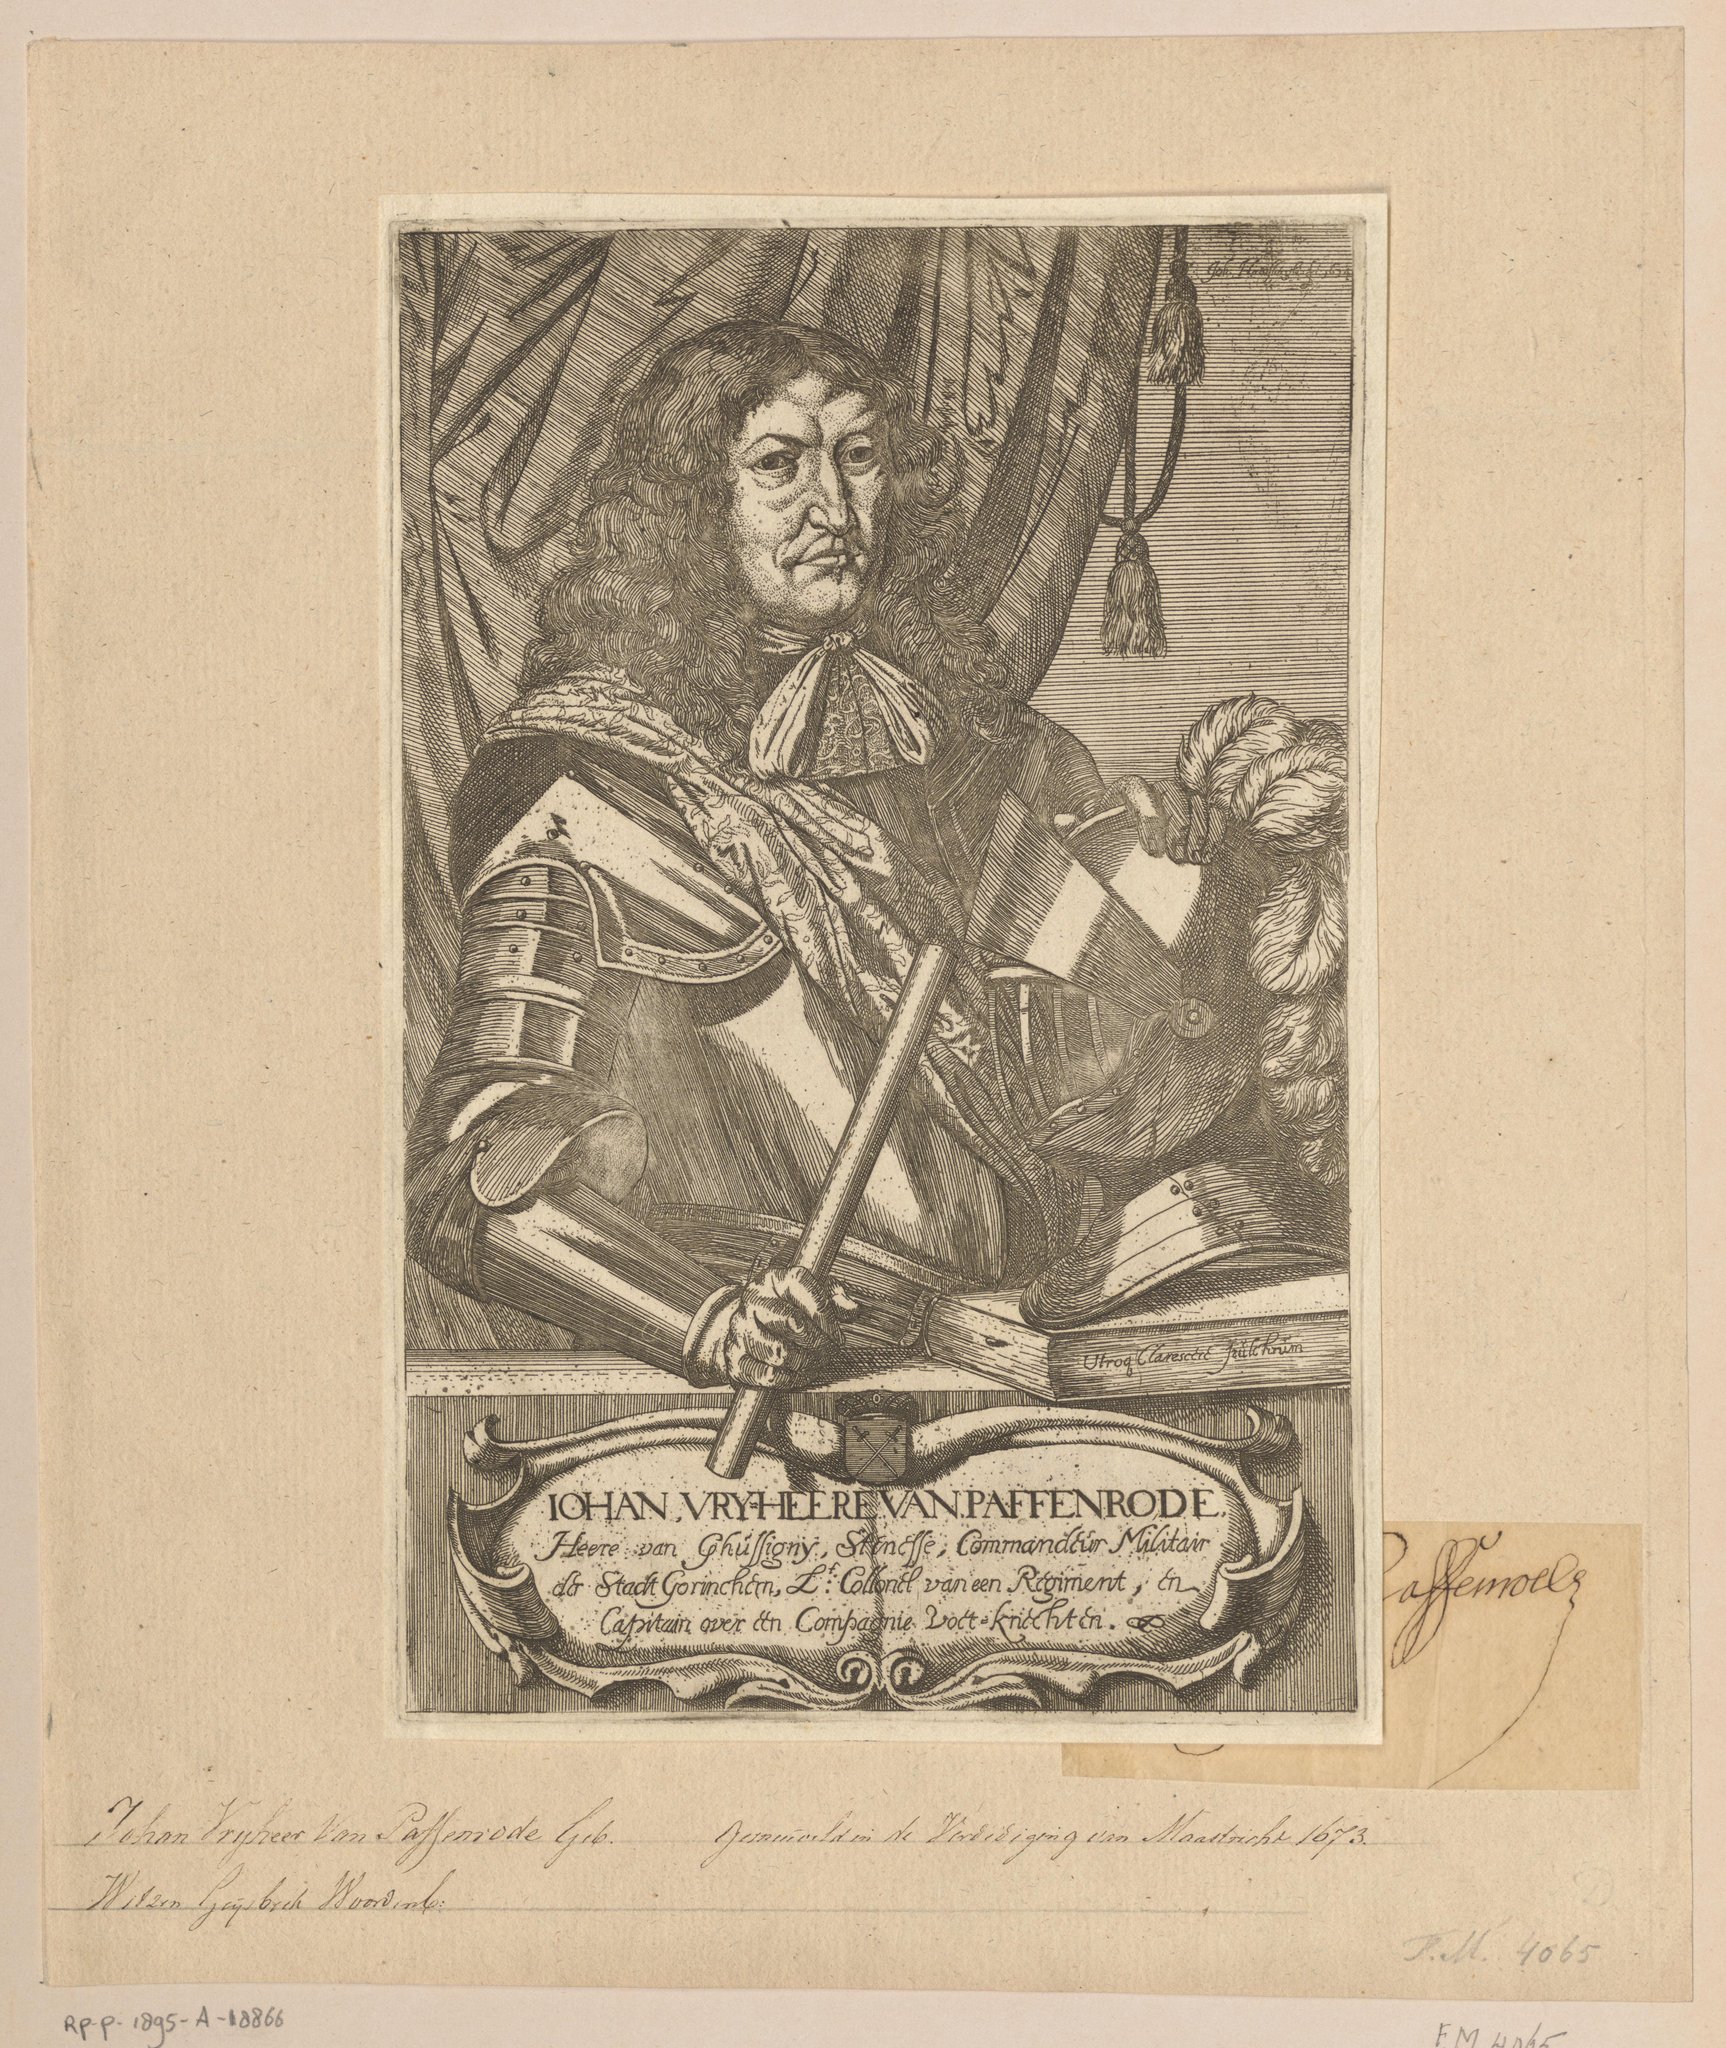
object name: print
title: Portret van Johan, vrijheer van Paffenrode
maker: jan van haensbergen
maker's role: painter, print maker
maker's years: 1642-1705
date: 1674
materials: paper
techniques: etching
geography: gorinchem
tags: maastricht, cuirass, adult man, historical persons, baton of general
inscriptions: inscription: ‘Johan Vryheer Van Paffenrode Geb. Gesneuveld in de Verdediging van Maastricht 1673./ Witzen Geijsbeek Woordenb:’, collector's mark: Lugt 2228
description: Op het blad is een kopie van de signatuur van Jan van Haensbergen geplakt.